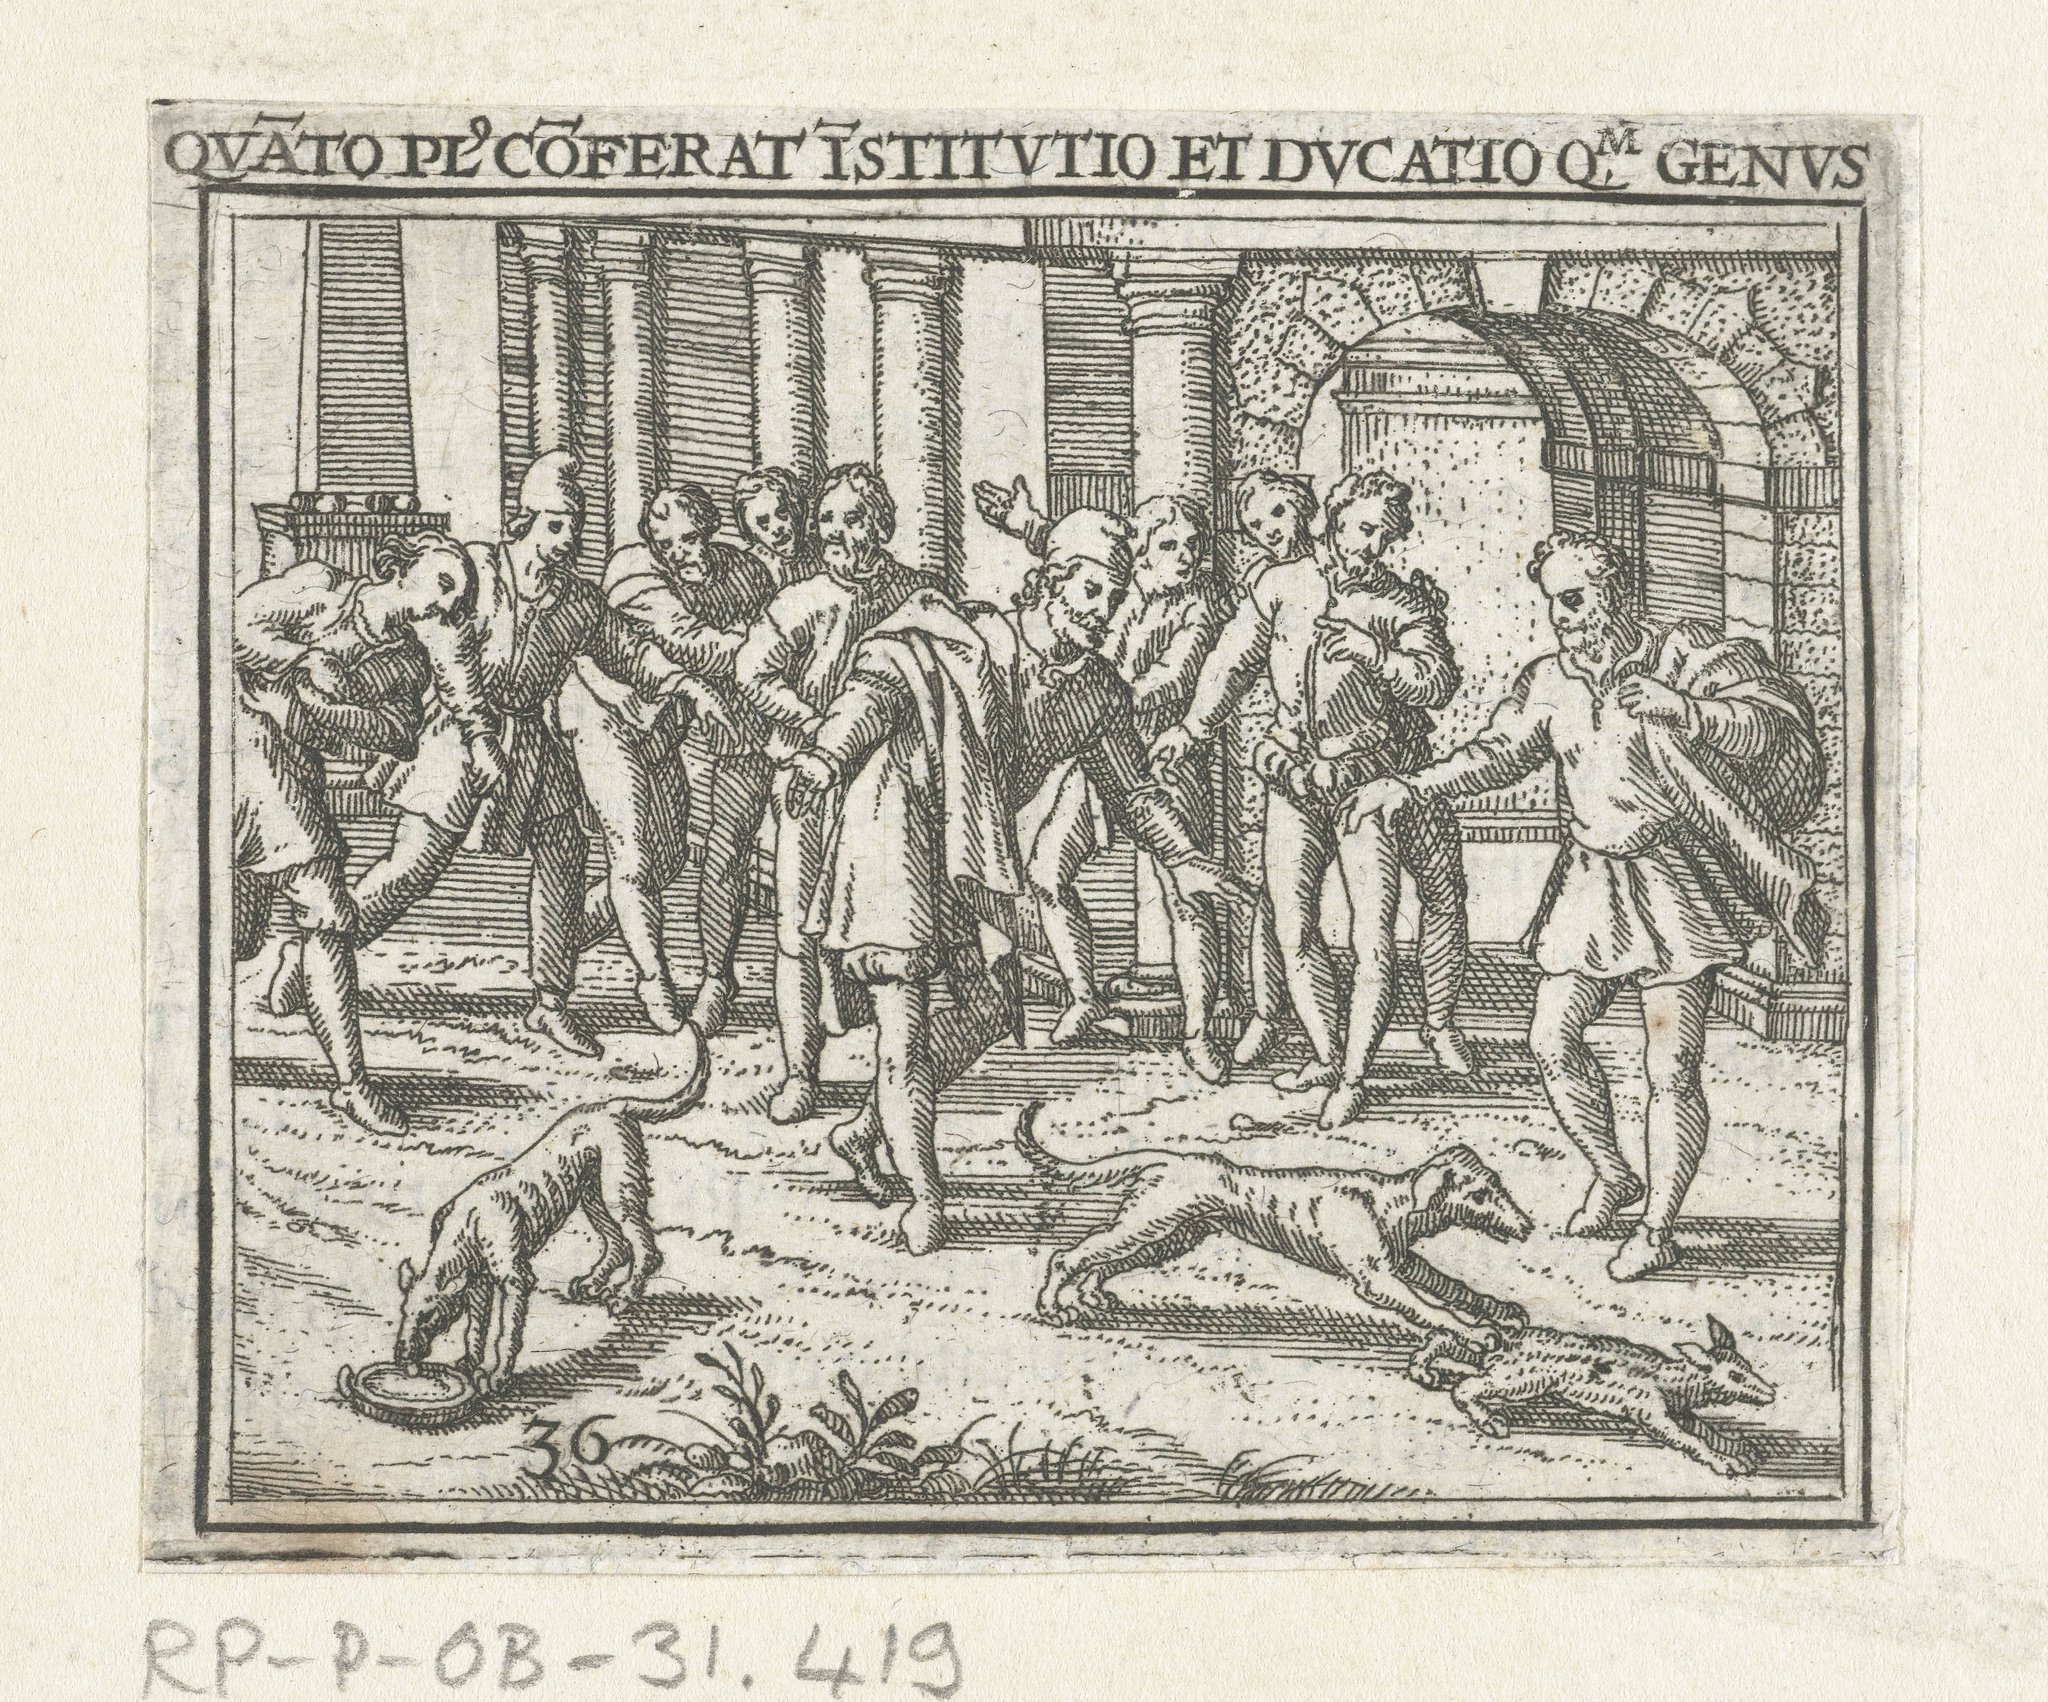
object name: print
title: QVATO PL. COFERAT ISTITVTIO ET DVCATIO Q. GENVS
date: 1596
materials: paper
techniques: engraving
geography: frankfurt am main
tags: dogs (racing)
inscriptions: collector's mark: Lugt 240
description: Een groep mannen kijkt naar een hondenwedstrijd. De ene hond rent achter de prooi aan, de andere drinkt eerste even water uit een bakje.